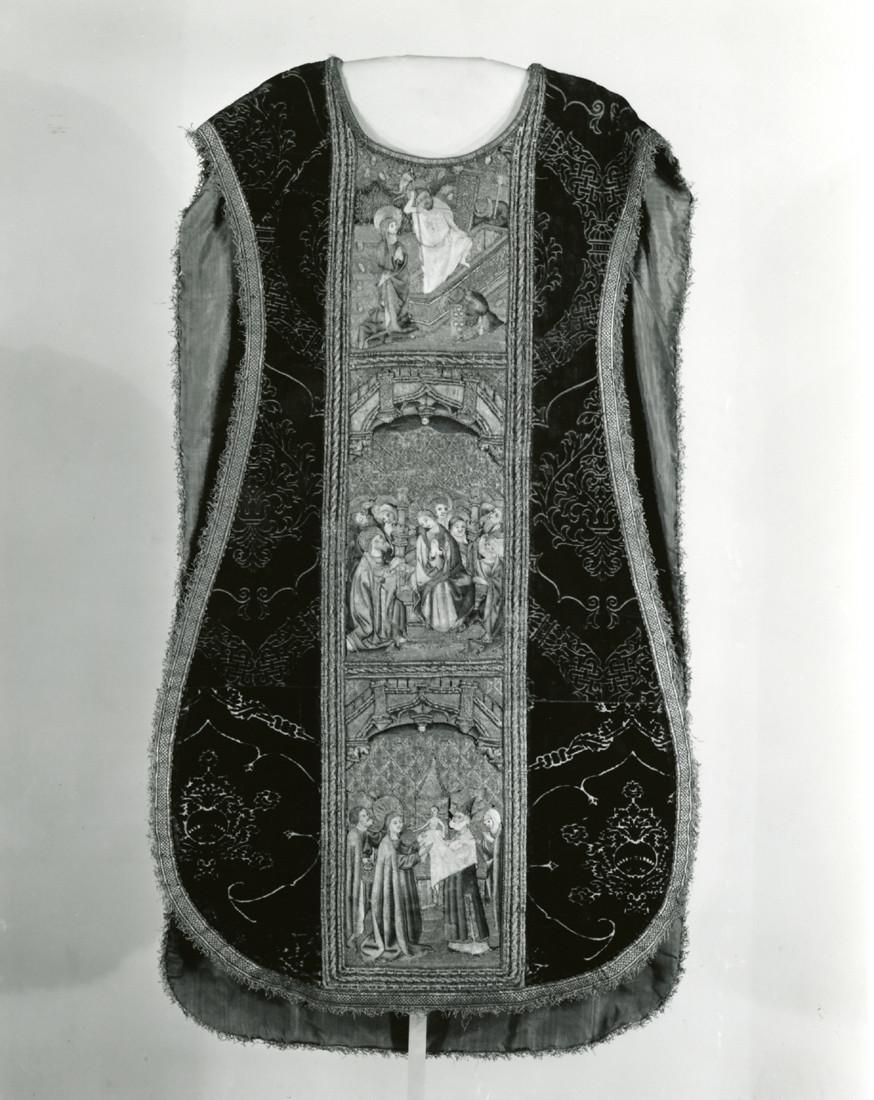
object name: chasuble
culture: spanish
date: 1401-1433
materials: metal thread, silk